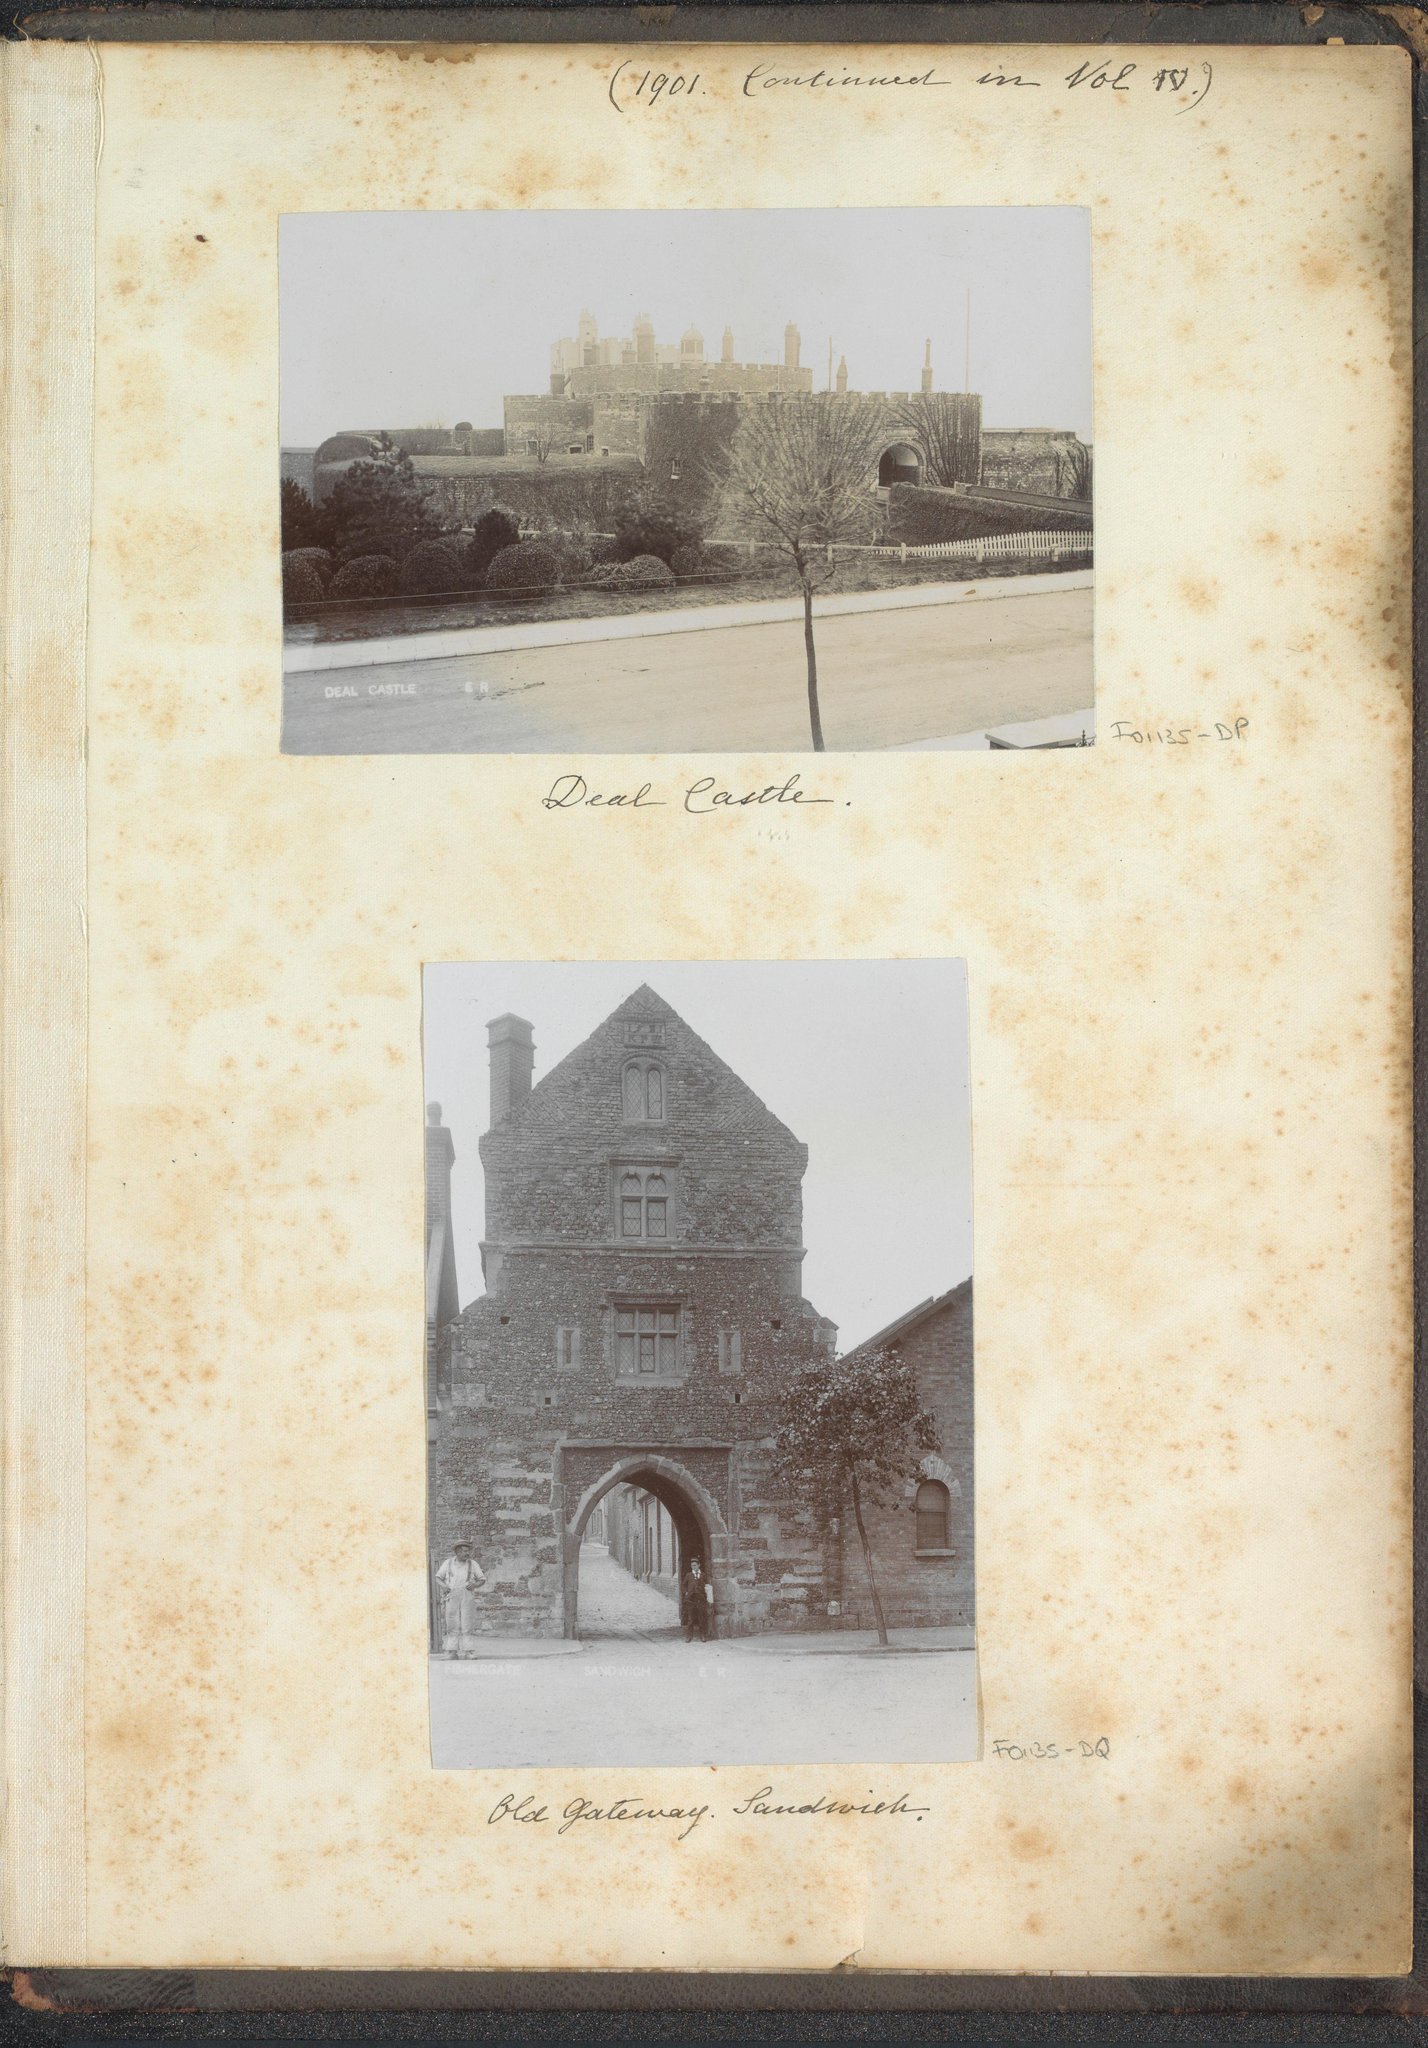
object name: photograph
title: Fishergate Sandwich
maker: Anonymous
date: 1901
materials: paper, photographic support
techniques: daylight paper print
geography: sandwich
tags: gate, entrance, city-gate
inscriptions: name: ‘ER’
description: Onderdeel van Reisalbum met foto's van bezienswaardigheden in Engeland en Frankrijk.